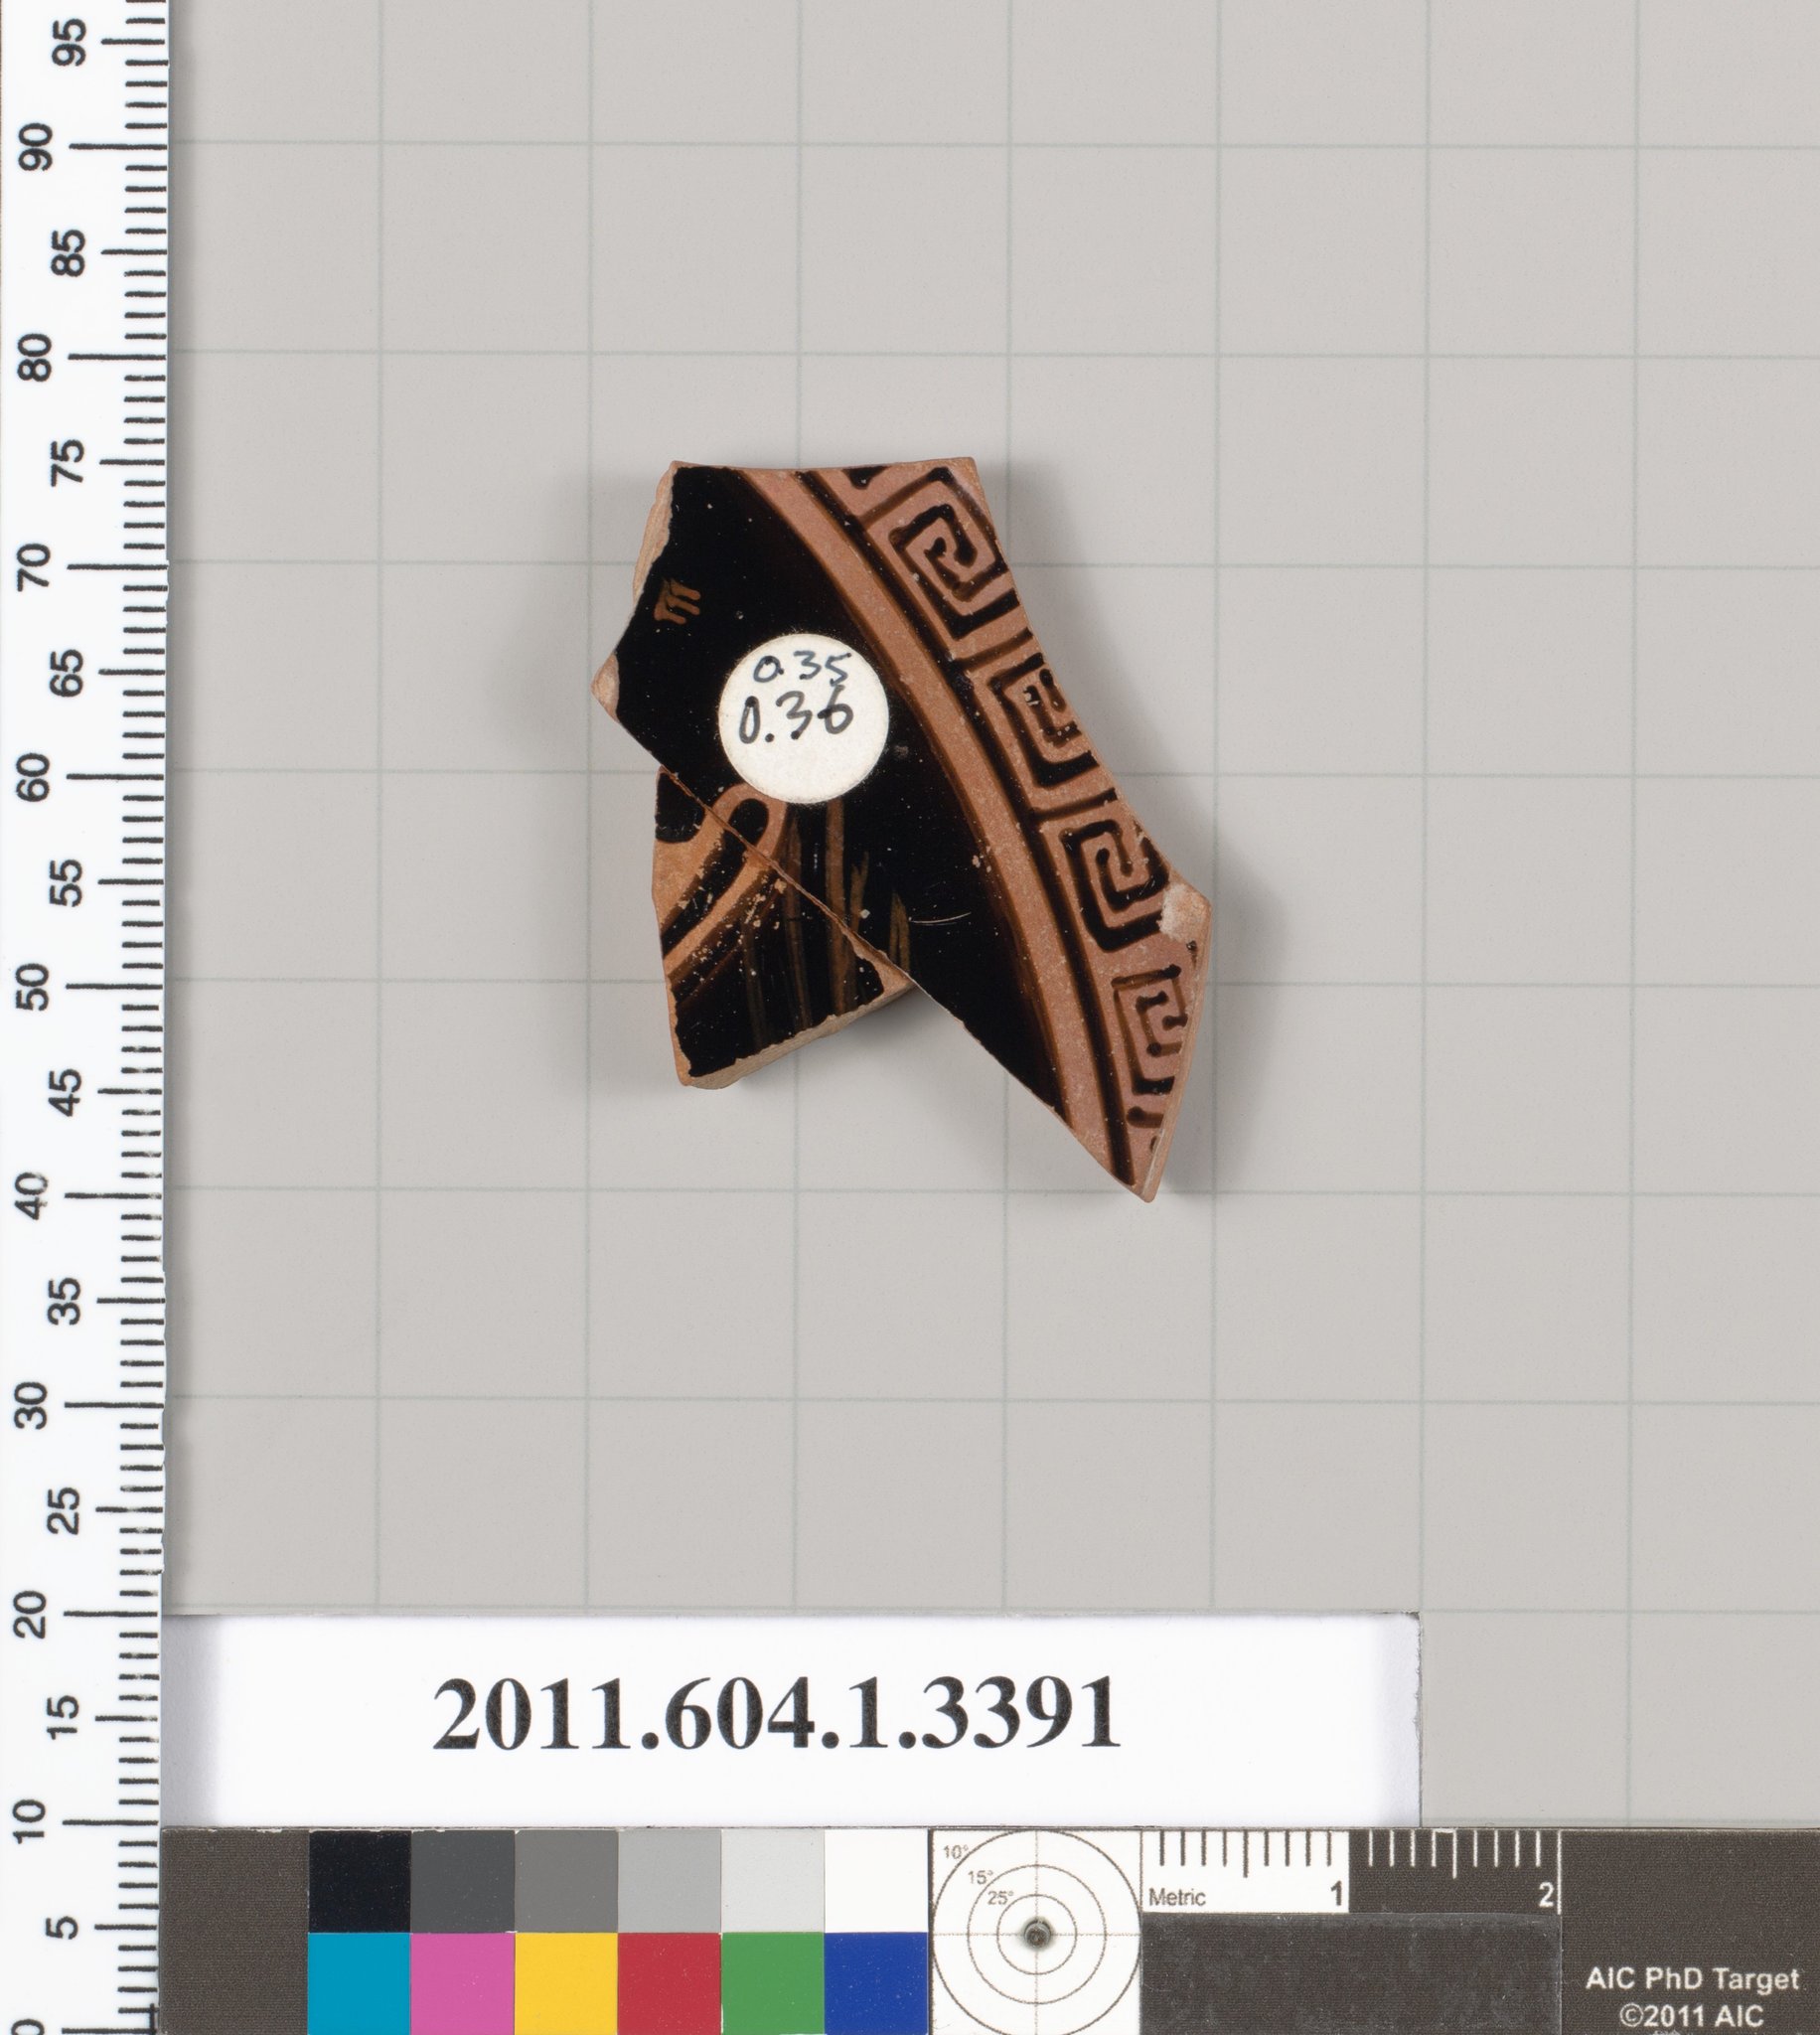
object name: kylix fragment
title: Terracotta fragment of a kylix (drinking cup)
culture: greek, attic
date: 534-468 BCE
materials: terracotta